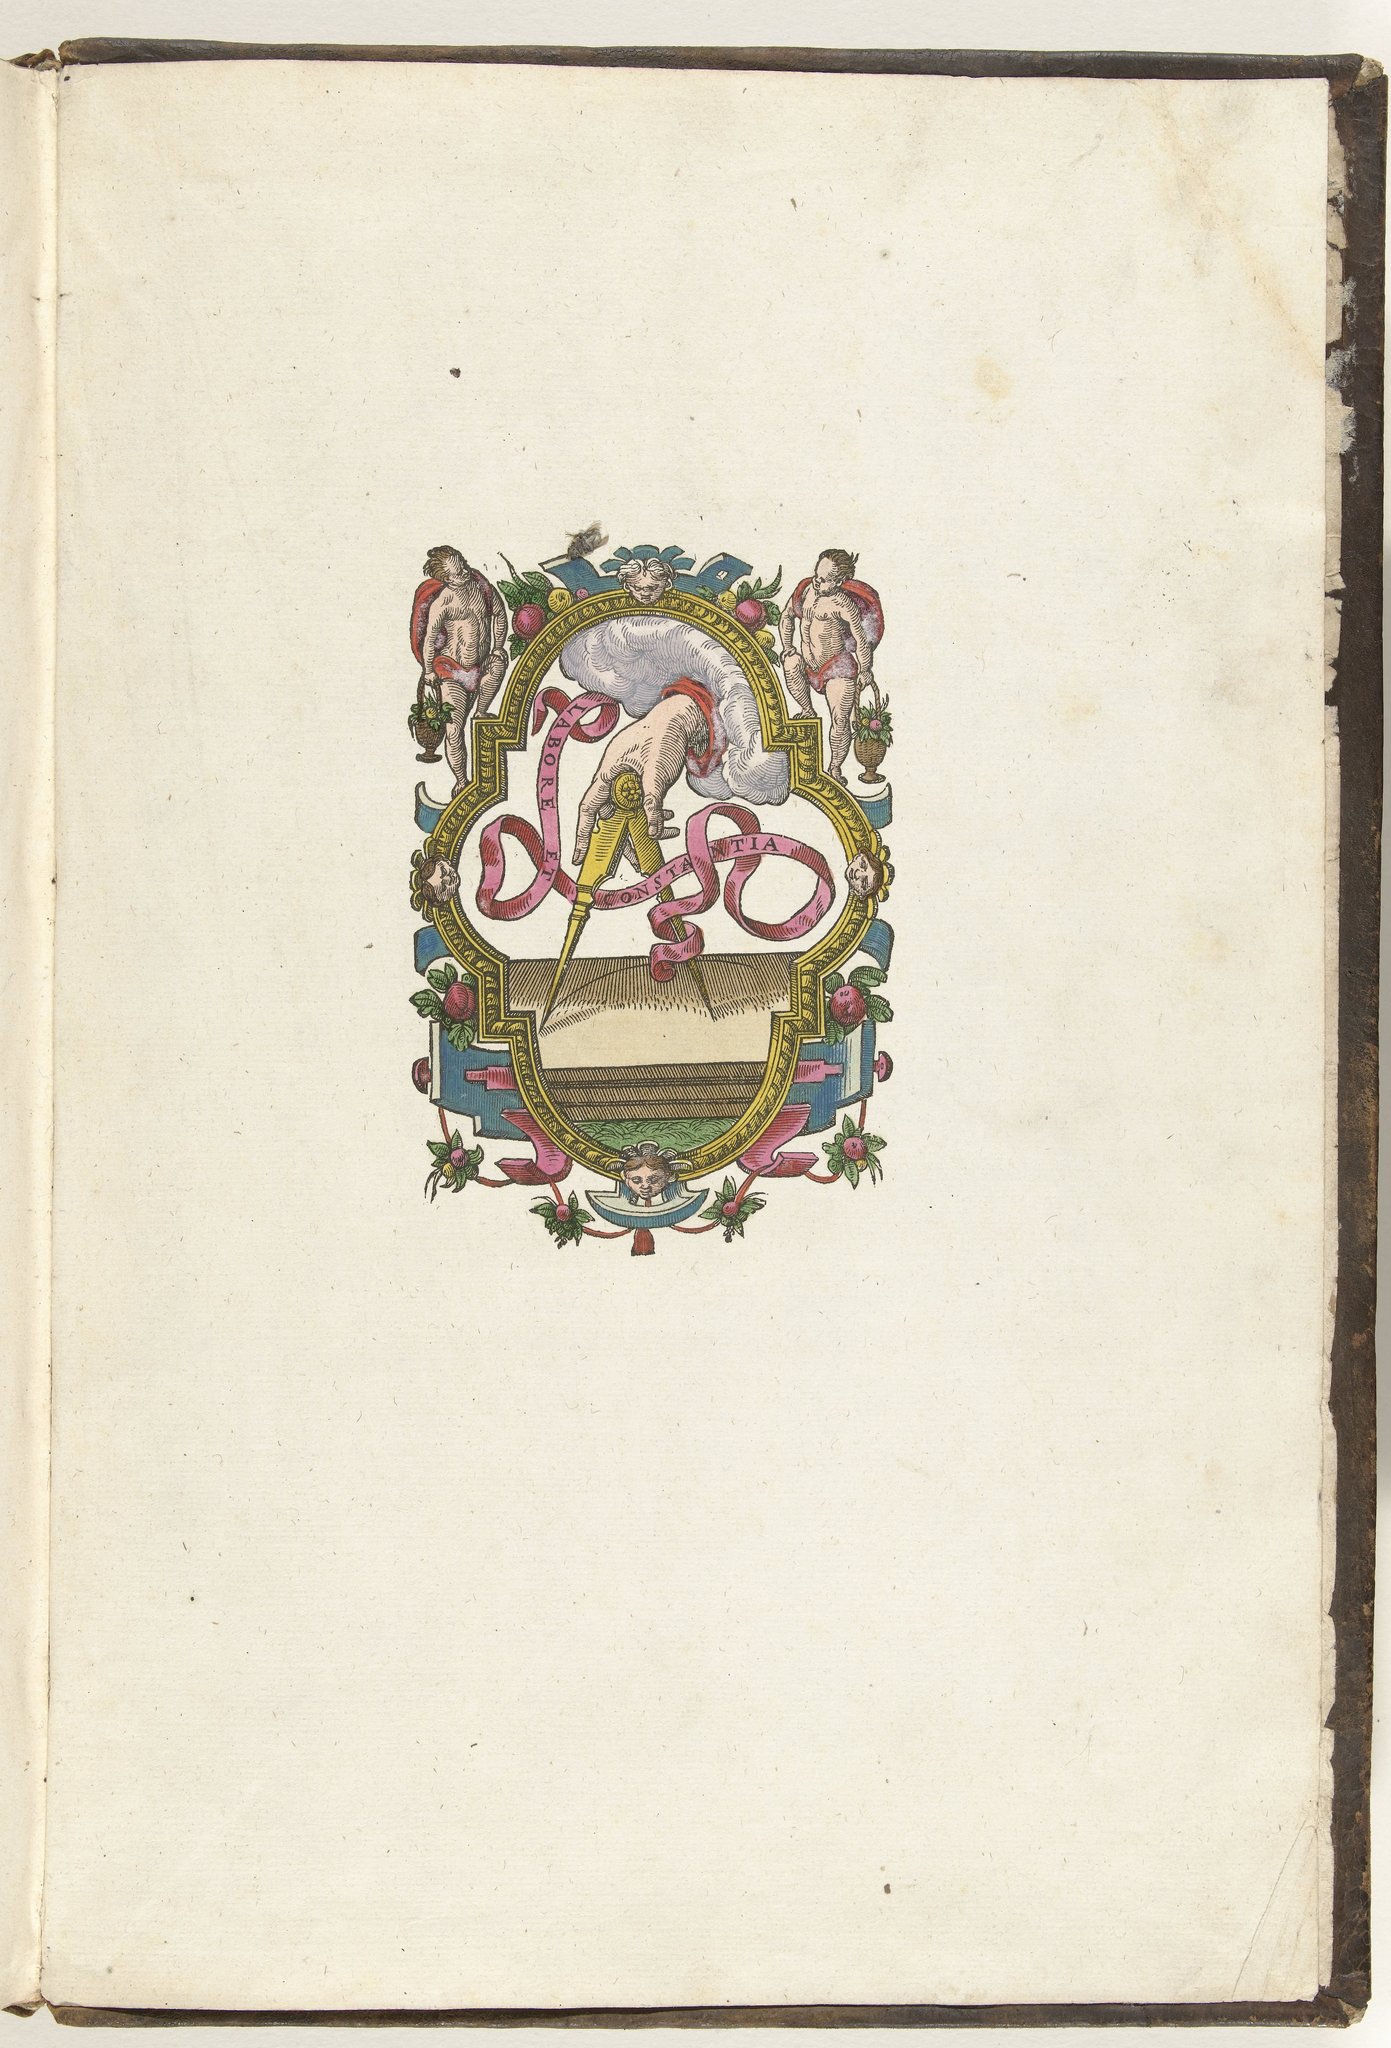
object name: print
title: Drukkersmerk van Plantijn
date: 1576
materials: paper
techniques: hand coloring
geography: antwerp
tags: device (trade-mark of printer or publisher)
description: Drukkersmerk van Plantijn. Hand met passer en het motto: Labore et Contantia. Op de laatste pagina in de complete beschrijving van de intochten van het paar te Brussel, Antwerpen, Gent en Valenciennes, 1599.